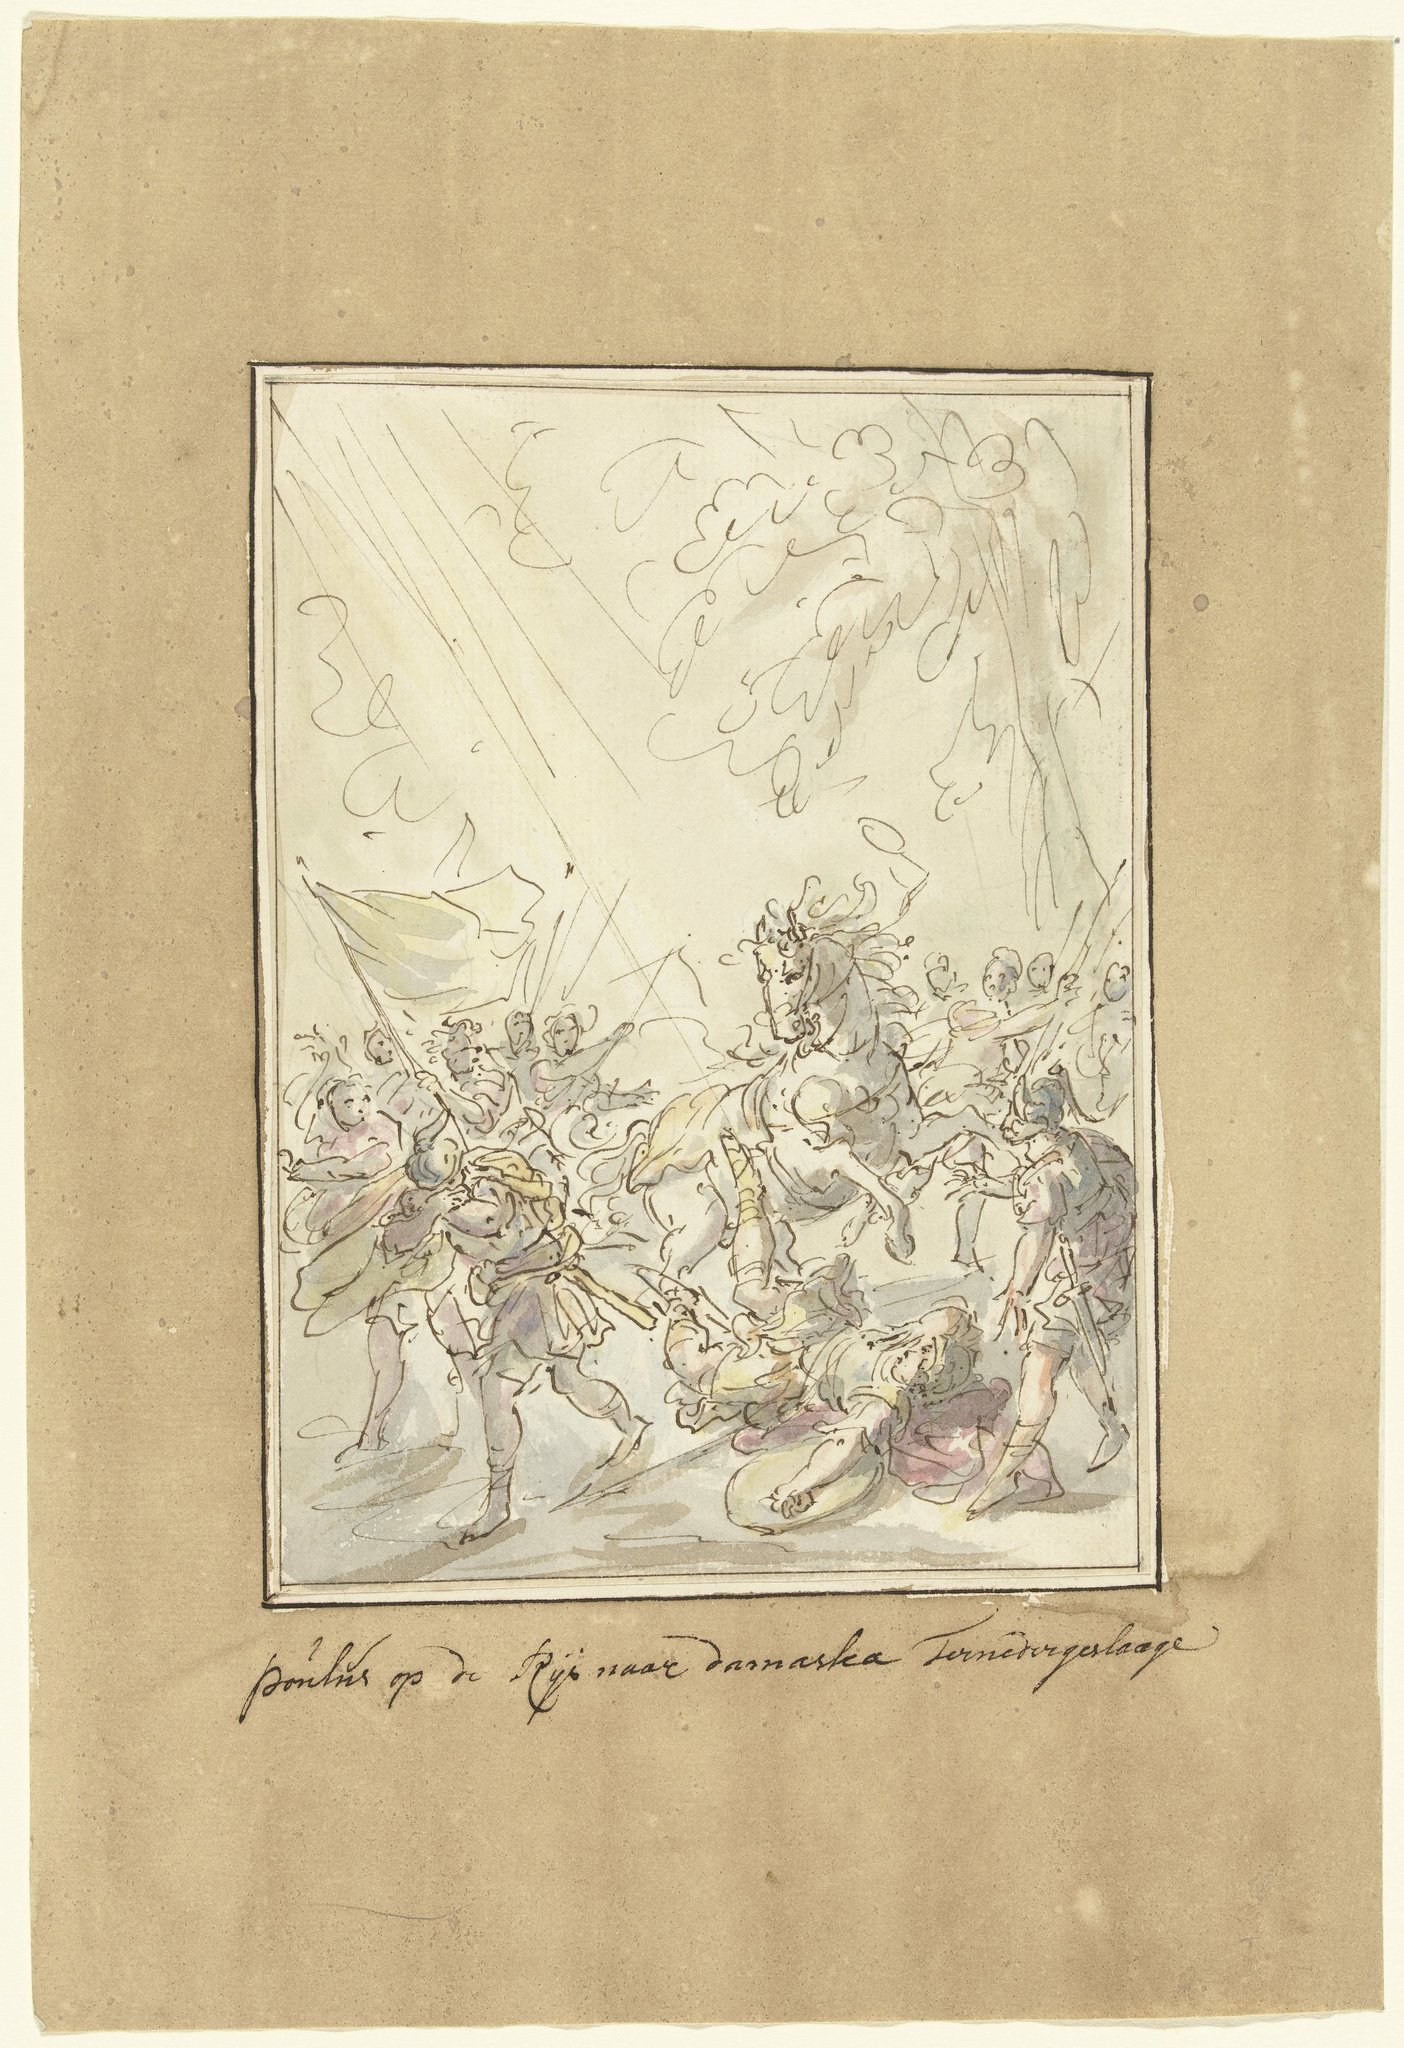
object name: design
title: De bekering van Paulus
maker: elias van nijmegen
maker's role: draughtsman, painter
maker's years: 1667-1755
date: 1677-1755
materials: ink, paper, pencil, watercolor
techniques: brush, pen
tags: on the way to damascus christ appears to saul, who falls from his horse and is blinded by the light